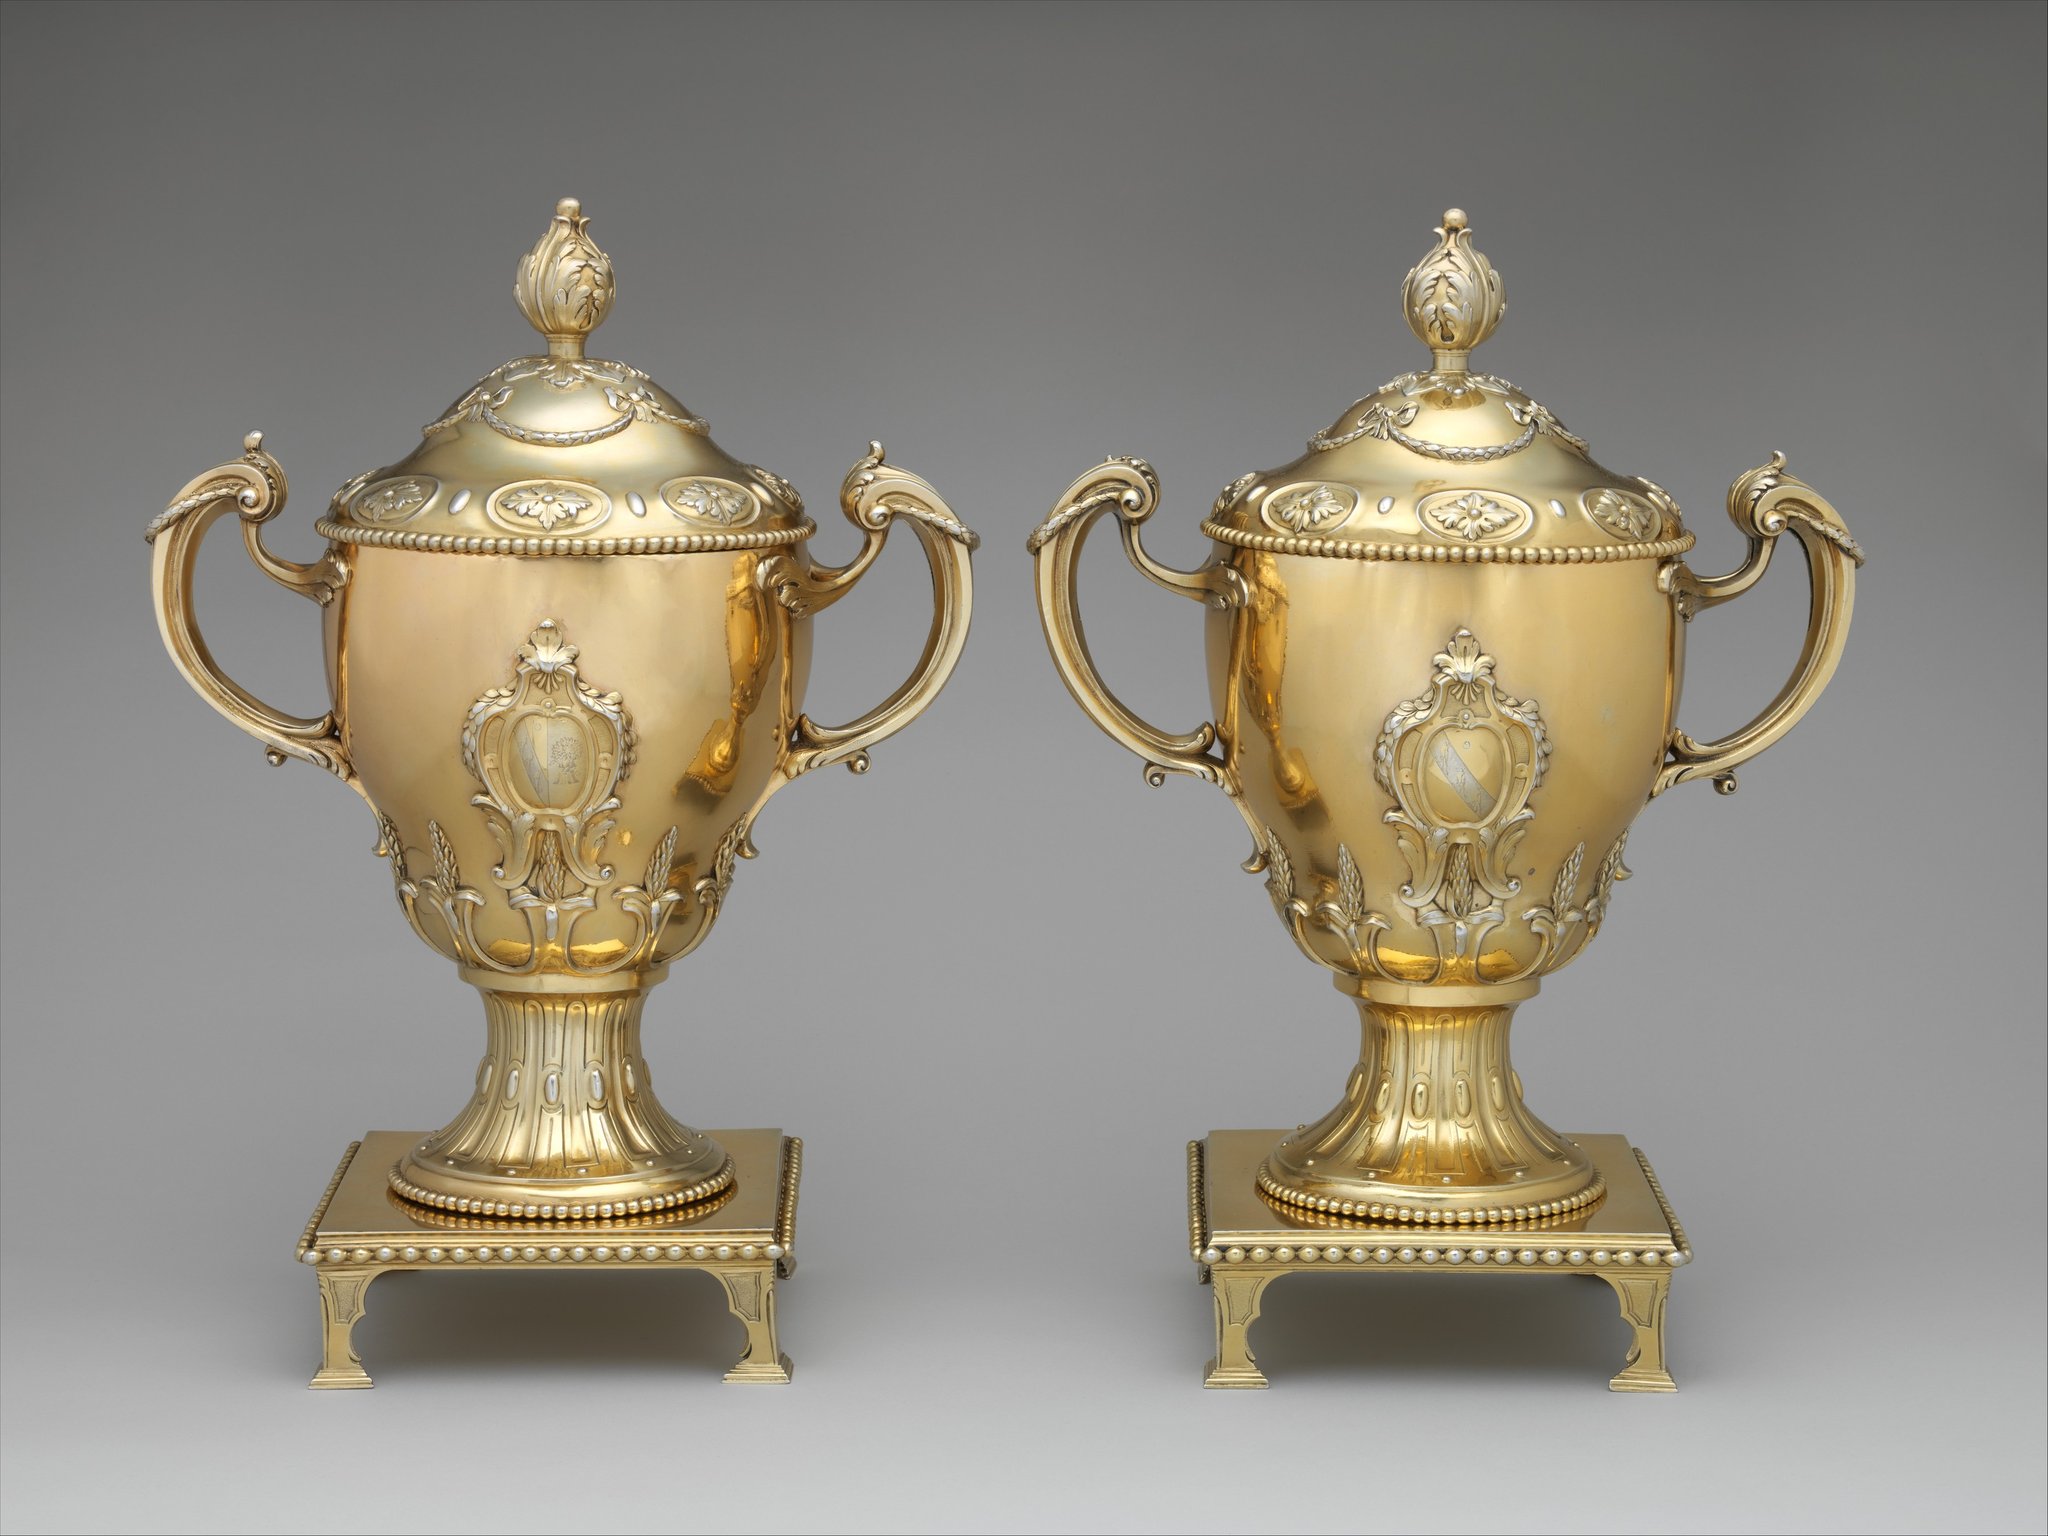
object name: cup with cover and stand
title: Cup with cover and stand (one of a pair)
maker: john parker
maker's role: maker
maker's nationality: british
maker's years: 1759-1777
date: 1766-1767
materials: silver gilt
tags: women,coat of arms